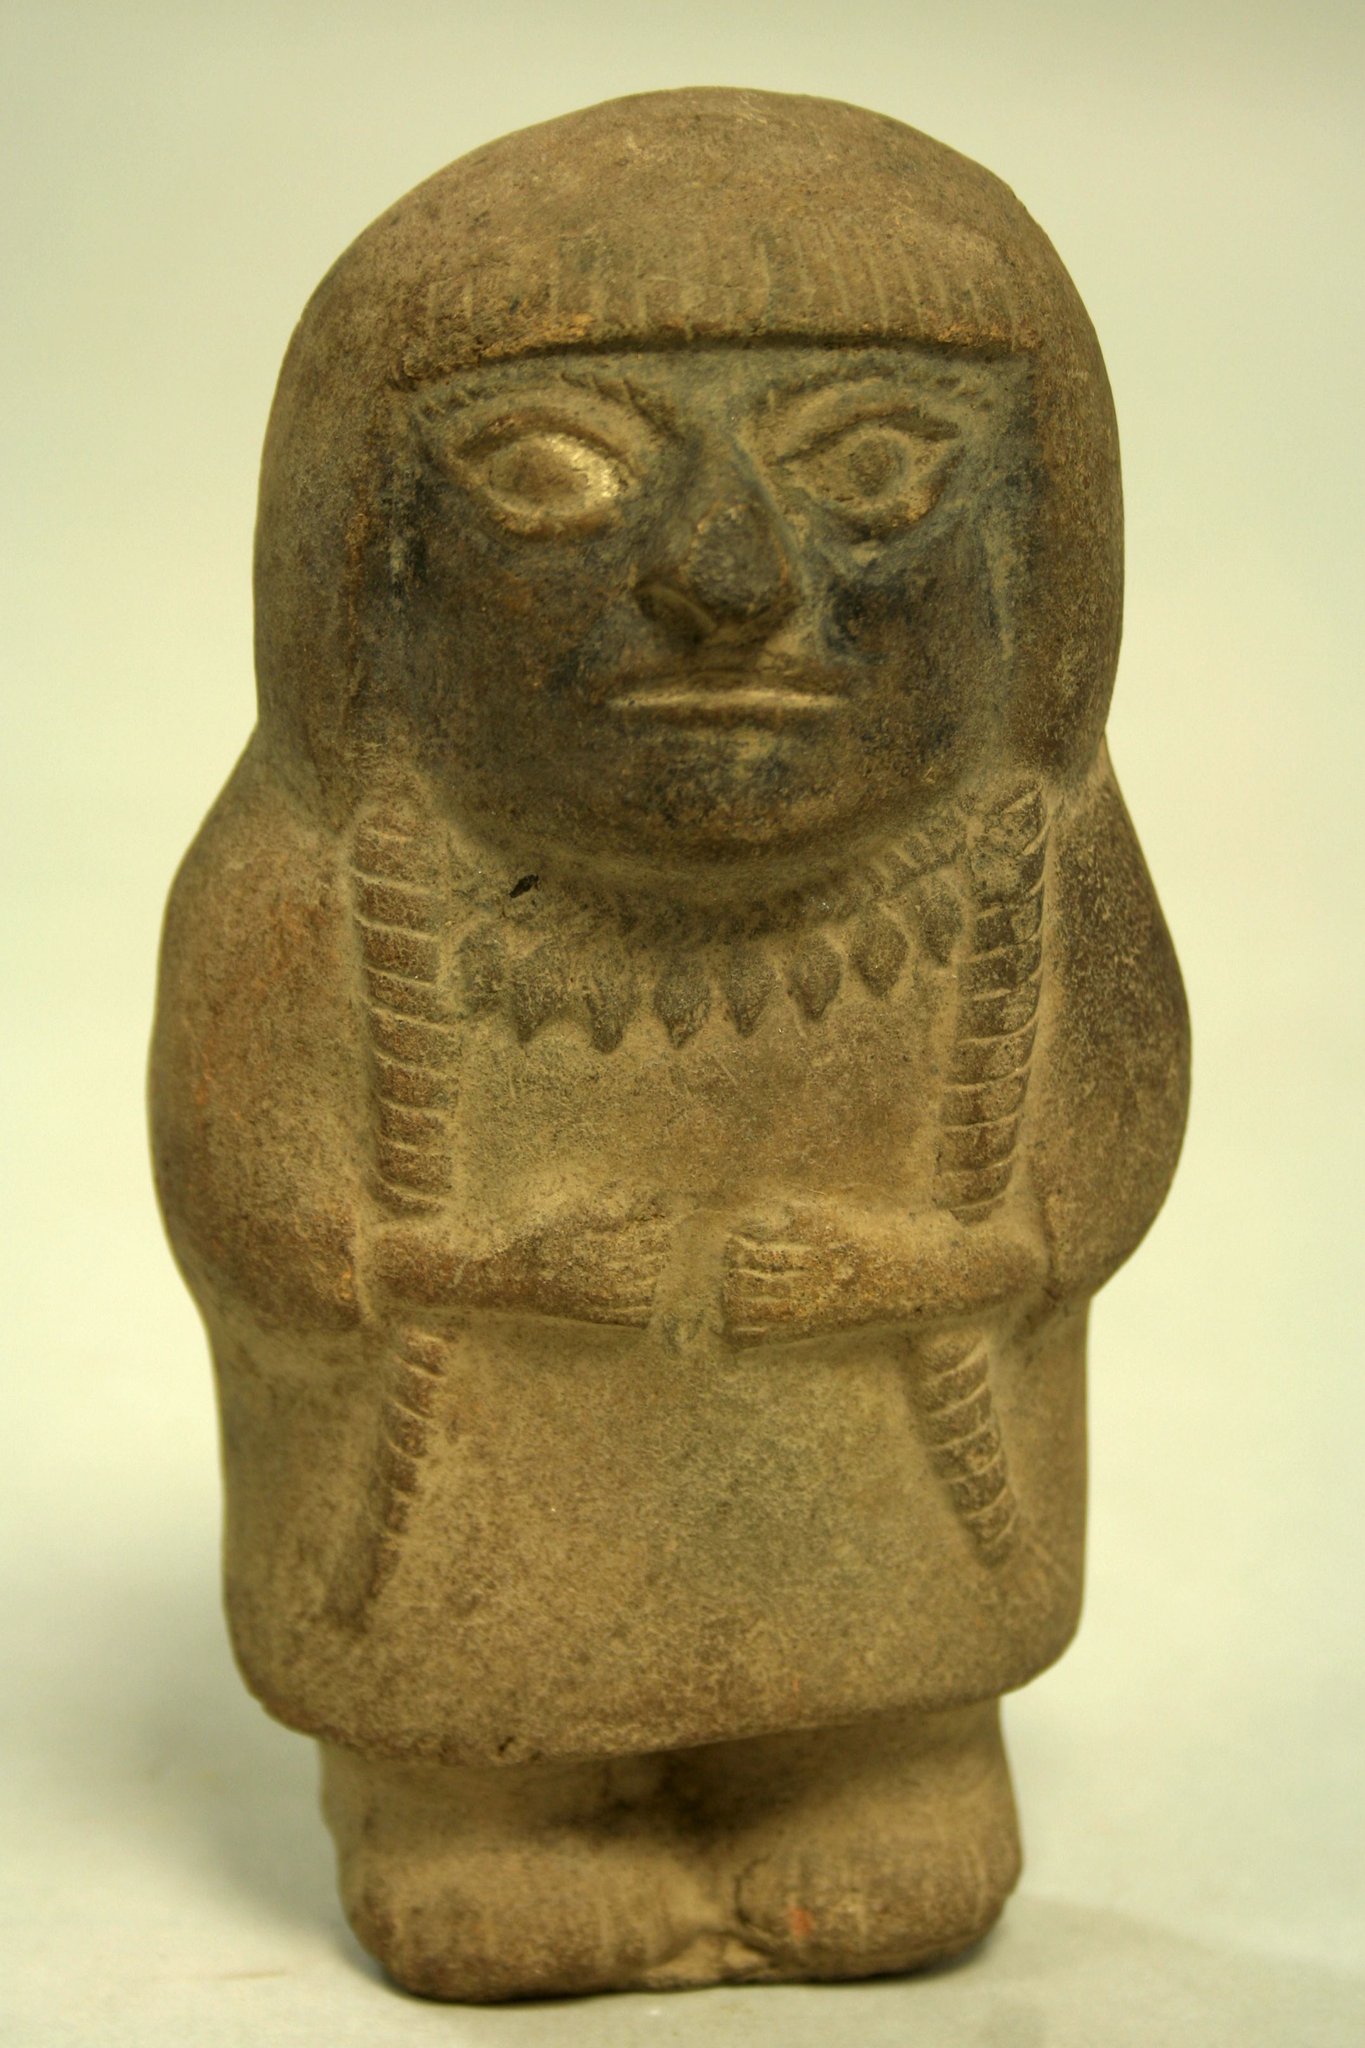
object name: figure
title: Standing Ceramic Figure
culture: moche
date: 201-500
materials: ceramic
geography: peru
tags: human figures